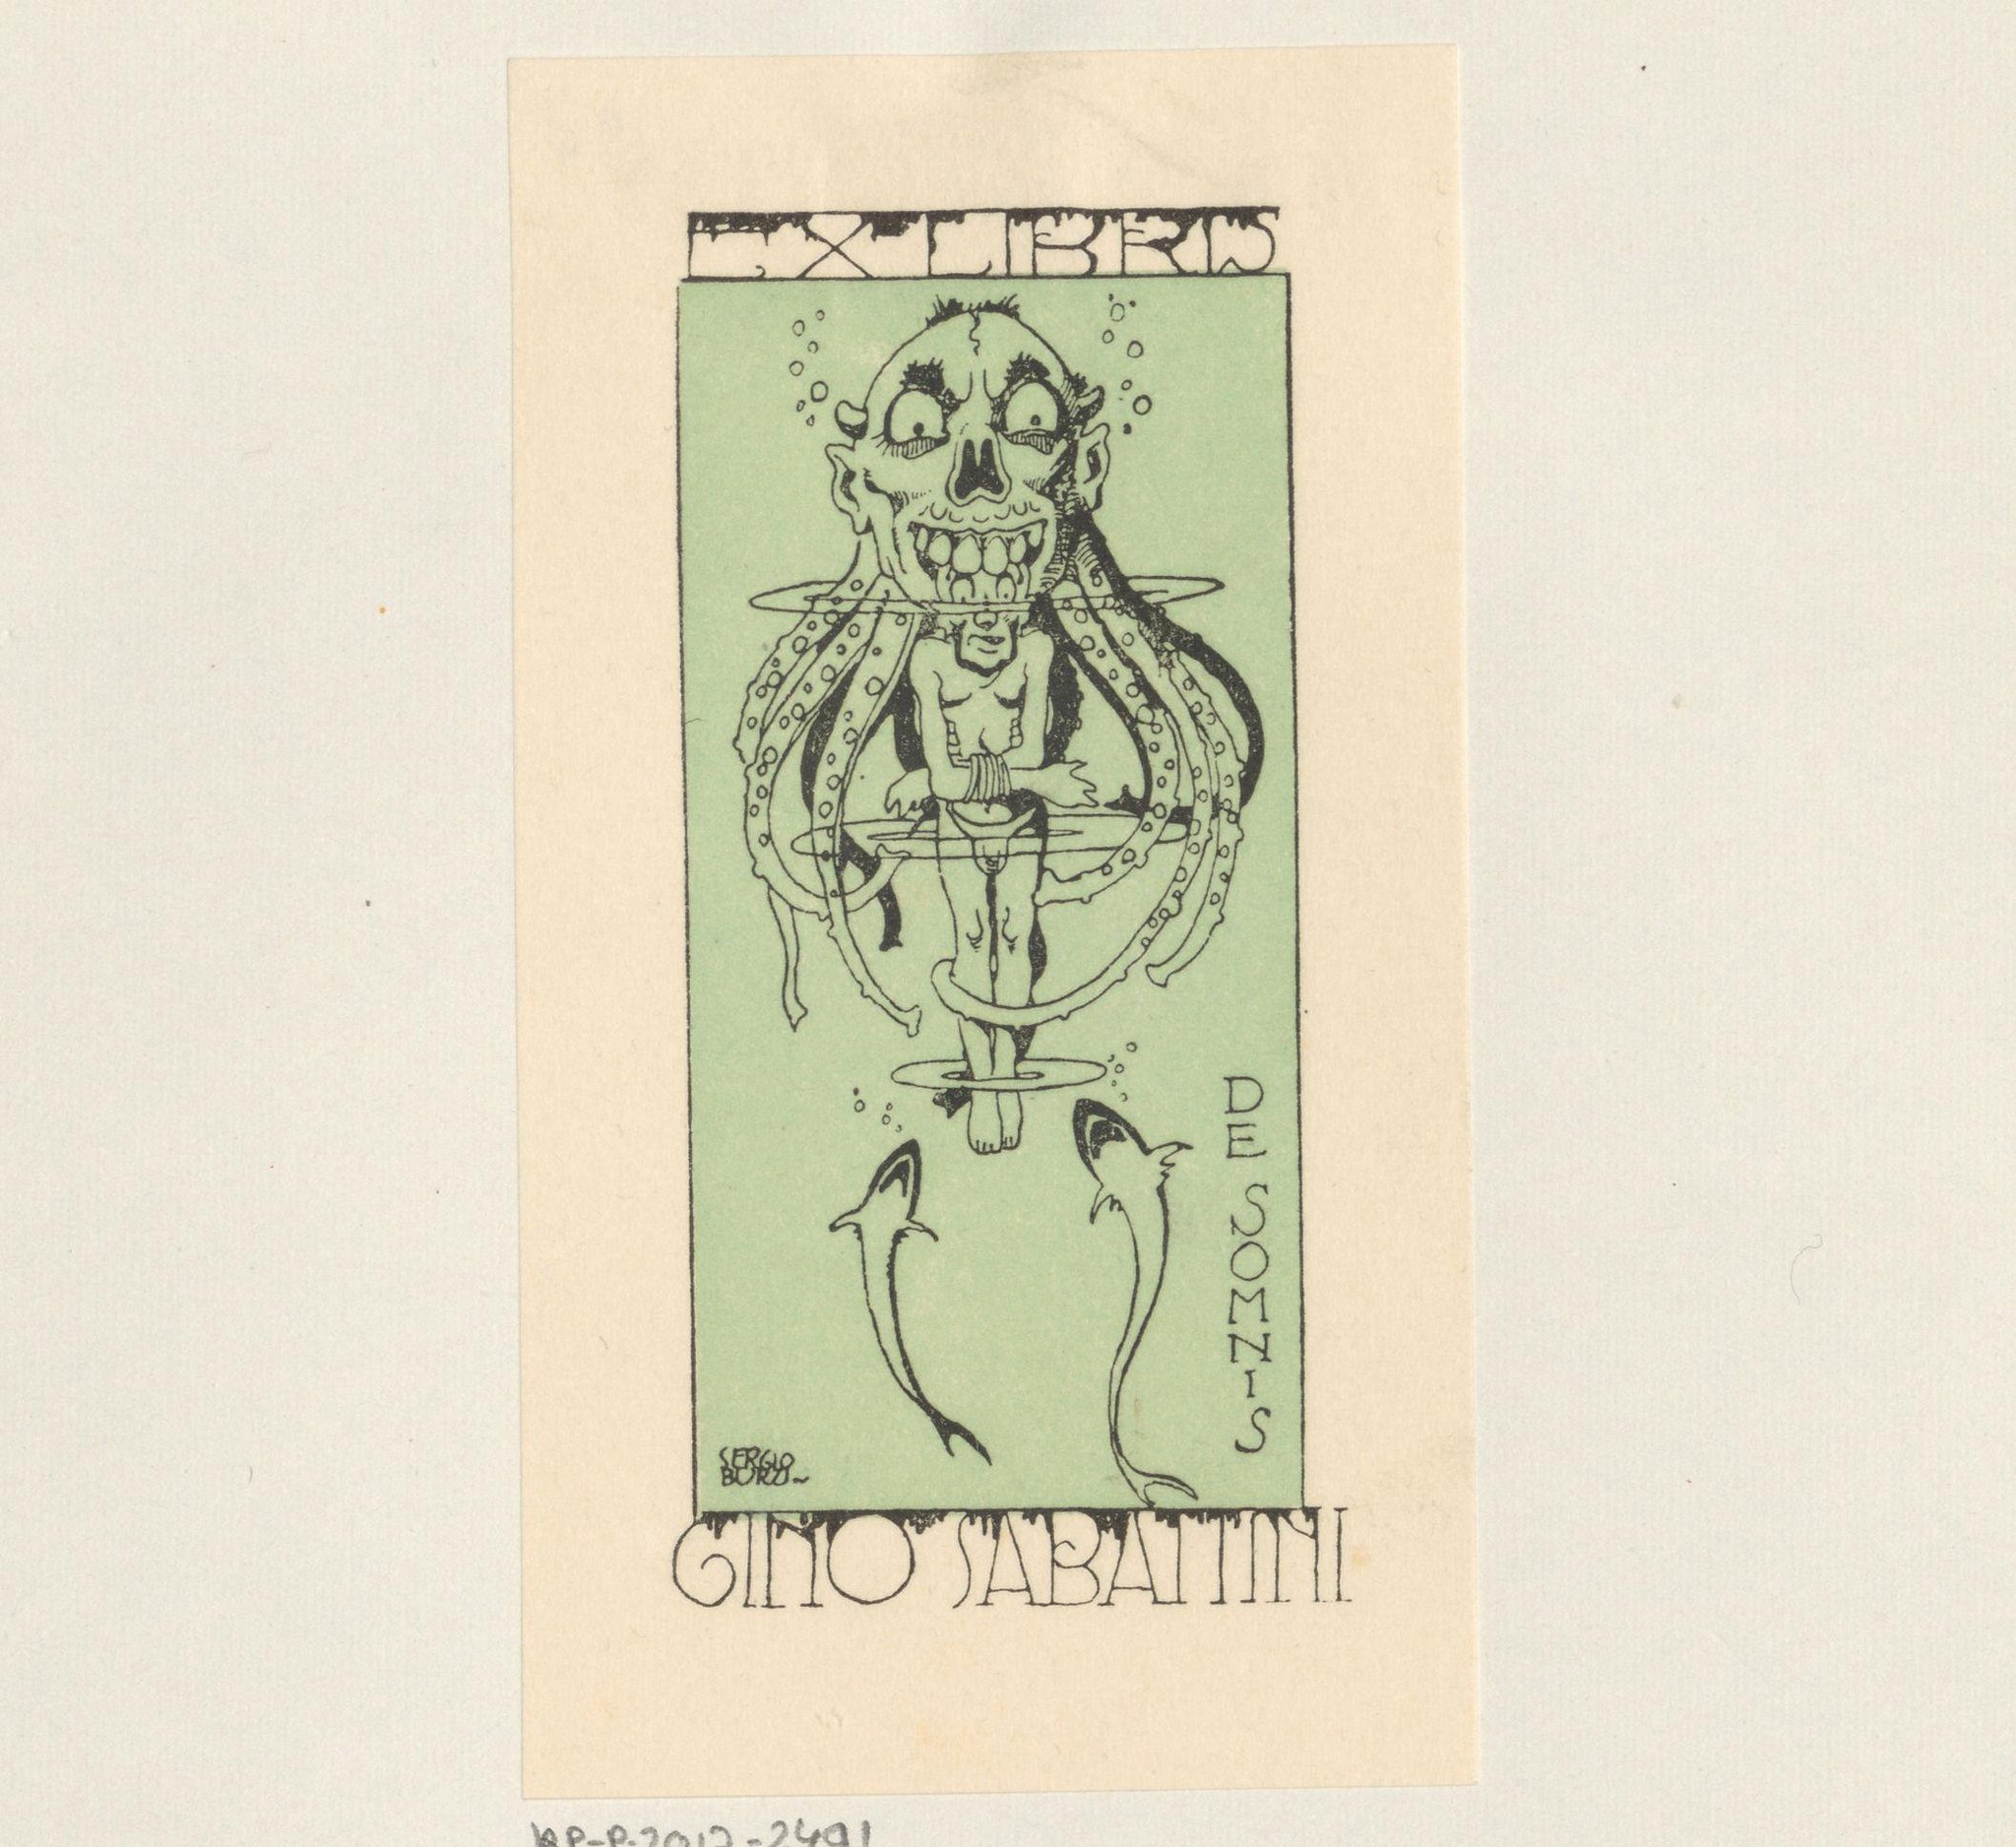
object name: bookplate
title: Ex libris van Gino Sabattini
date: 1940-1950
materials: paper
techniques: planographic printing, printing block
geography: italy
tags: gino sabattini, molluscs: octopus, monsters of the sea, cartilaginous fishes: shark, man (showing himself) undressed, quasi-nude